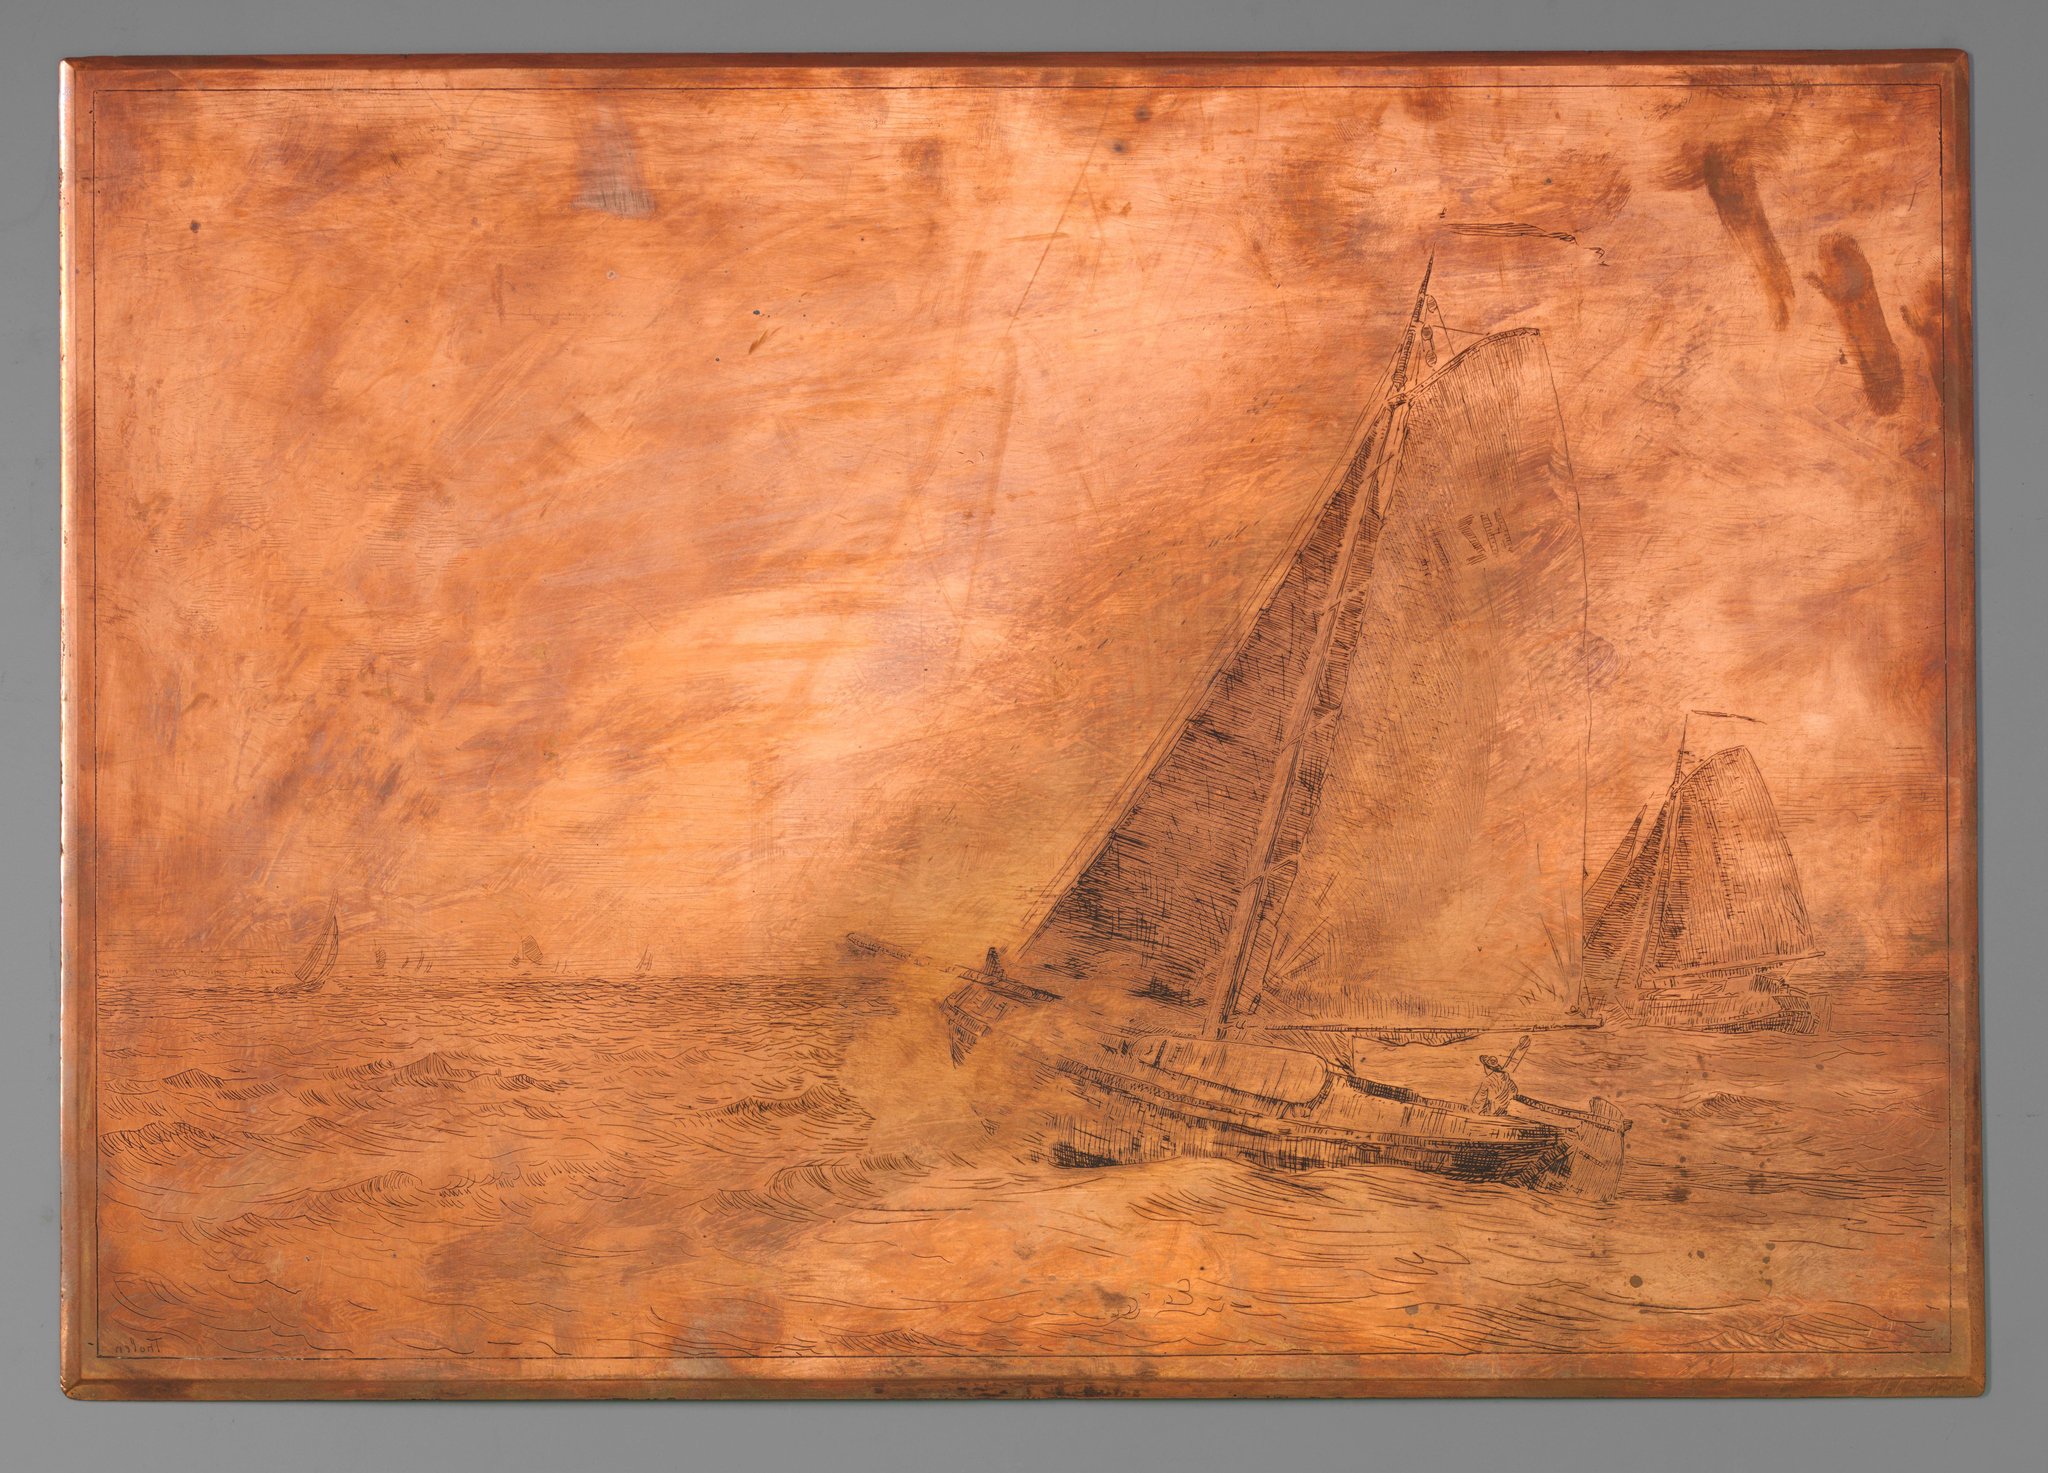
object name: copper plate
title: Zeilschepen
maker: willem bastiaan tholen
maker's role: draughtsman, painter, print maker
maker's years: 1860-1931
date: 1870-1909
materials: copper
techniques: etching